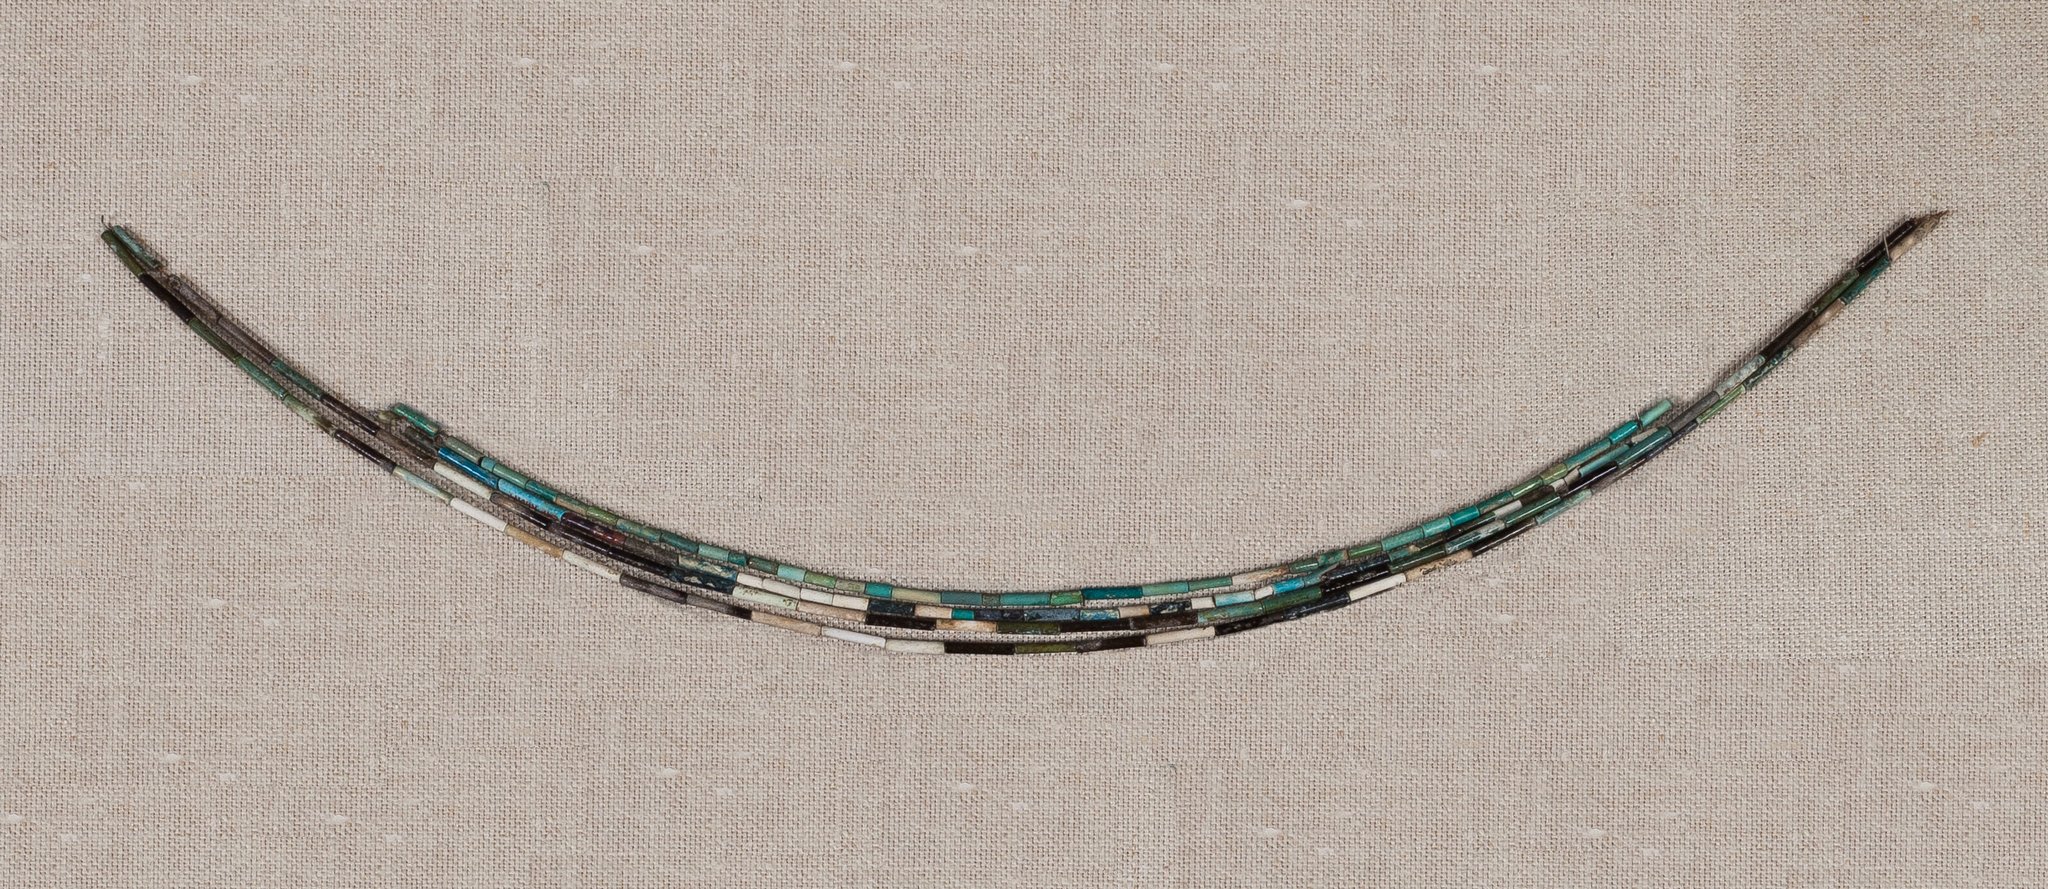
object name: necklace, bead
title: Necklace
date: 1981-1295 BCE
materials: faience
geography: egypt